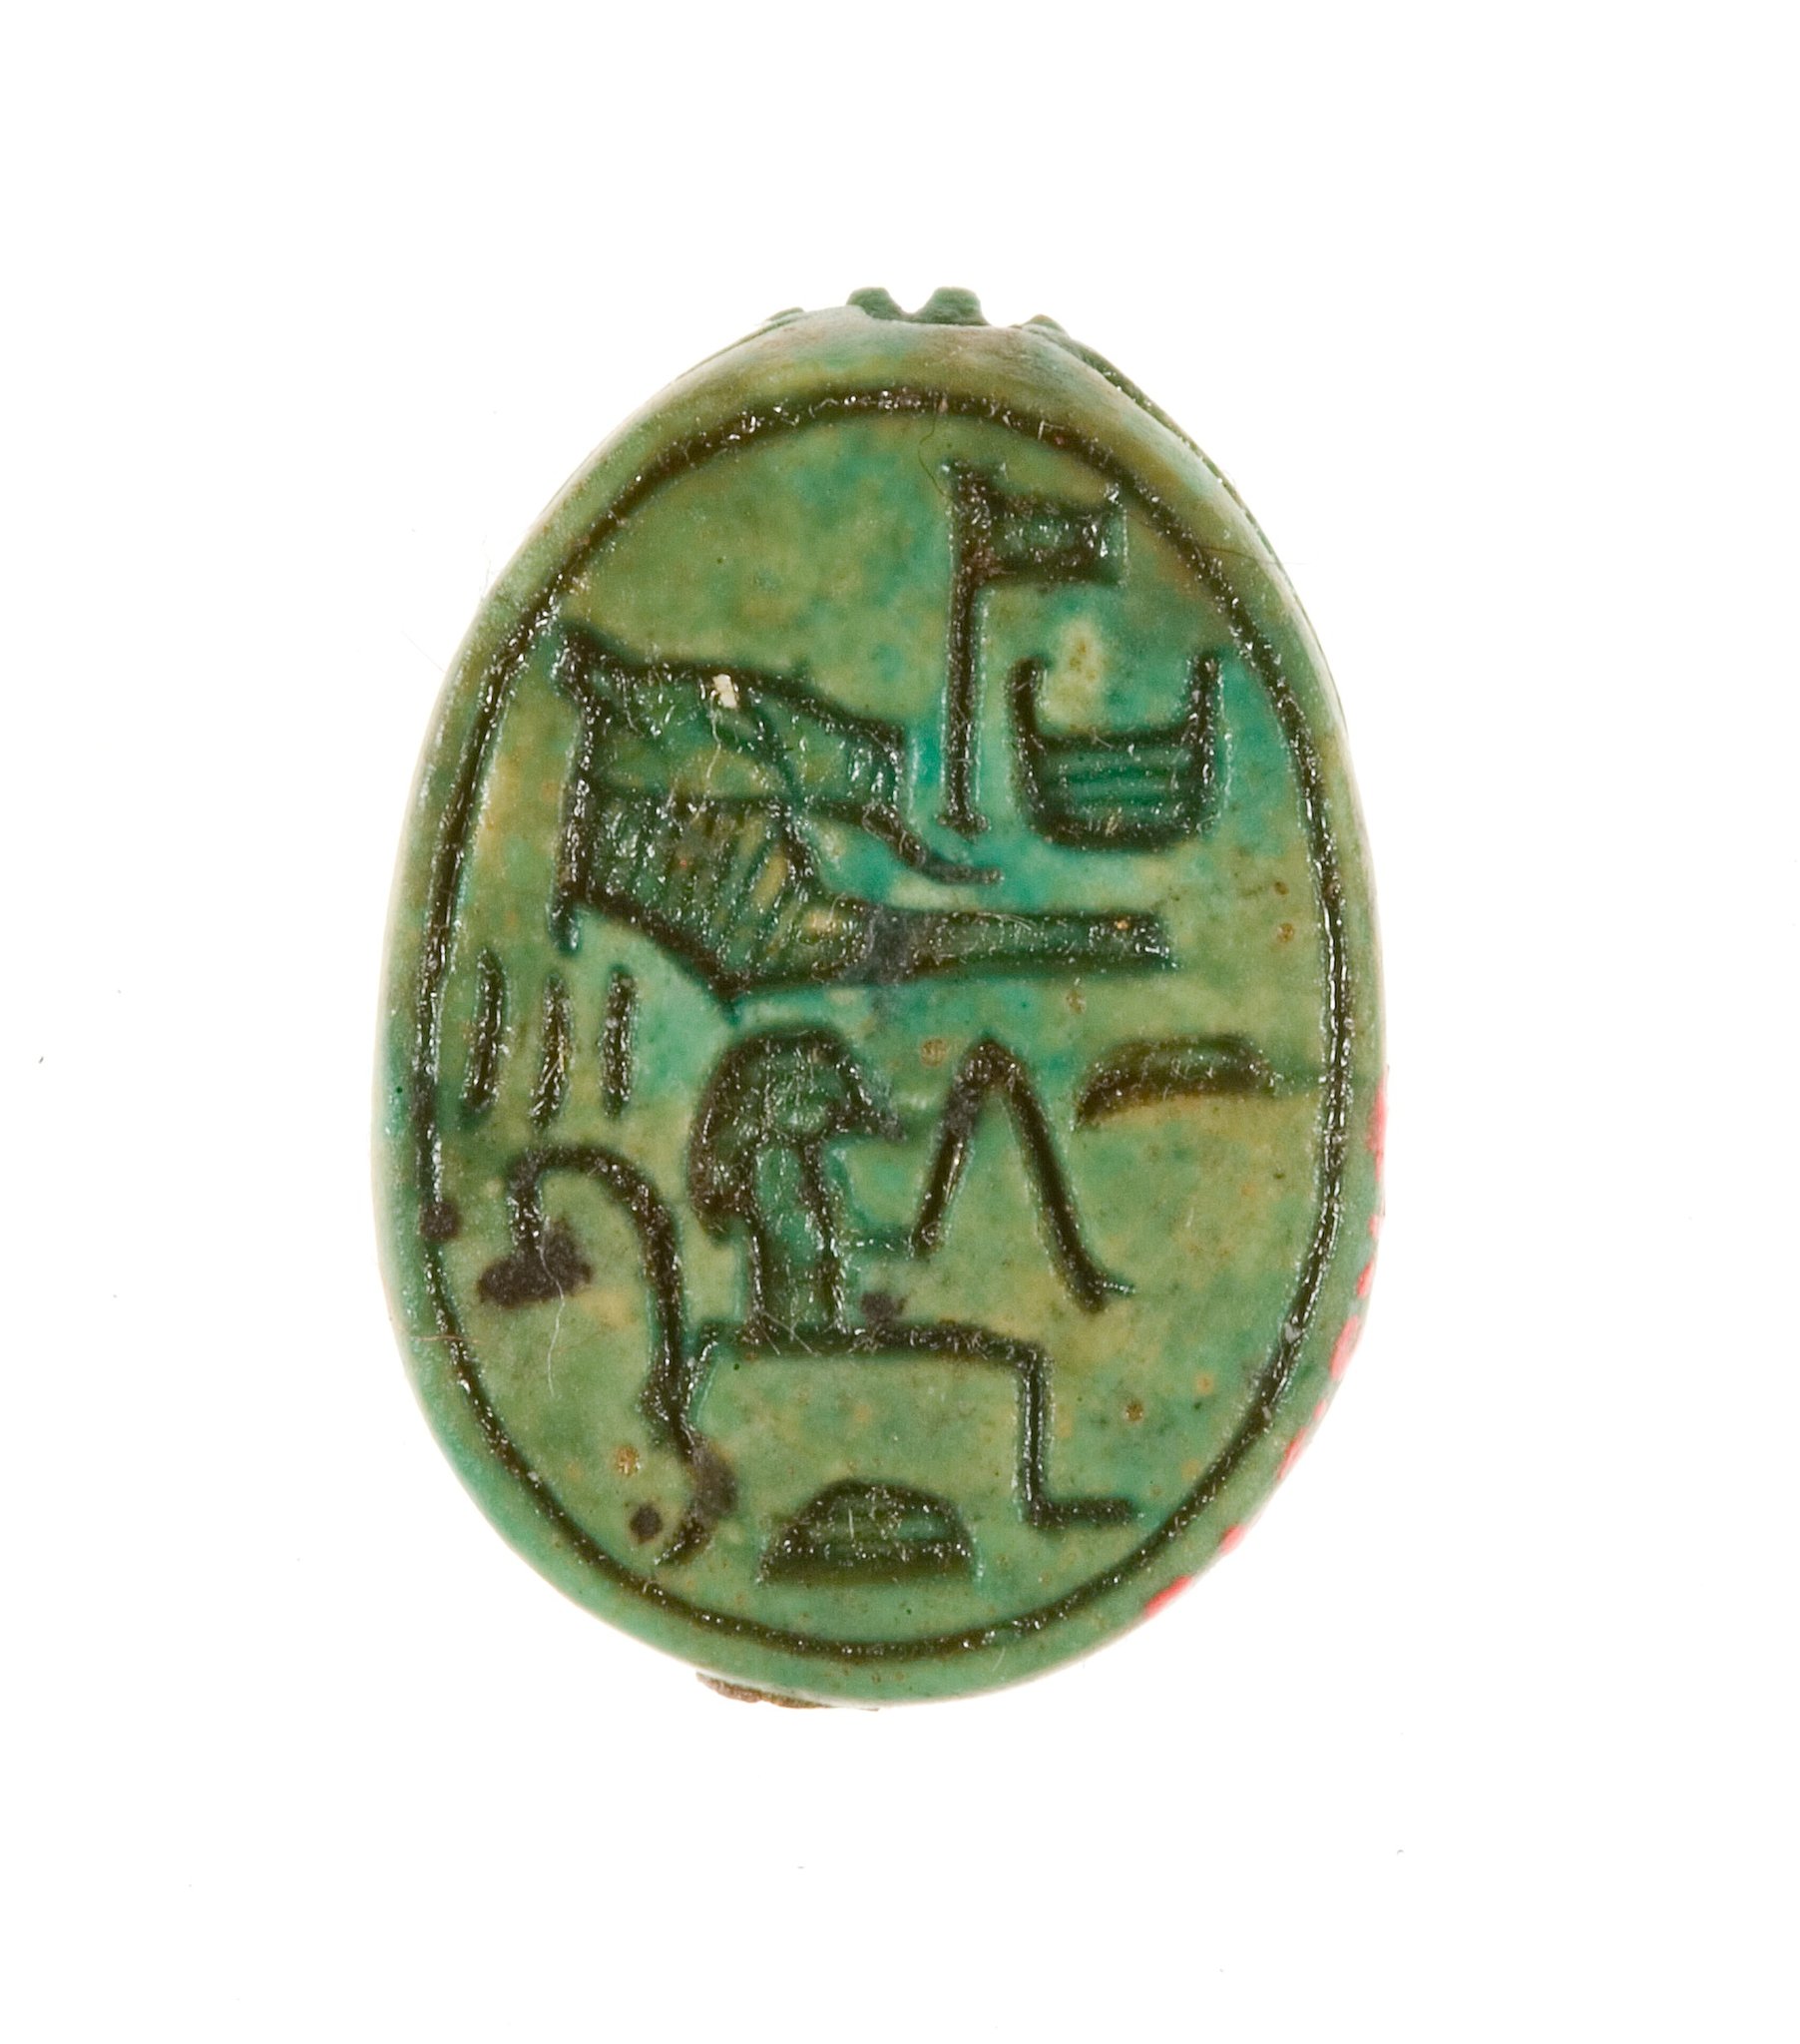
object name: scarab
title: Scarab Inscribed for the God's Wife Hatshepsut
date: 1479-1458 BCE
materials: stone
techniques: glazing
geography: egypt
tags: scarabs